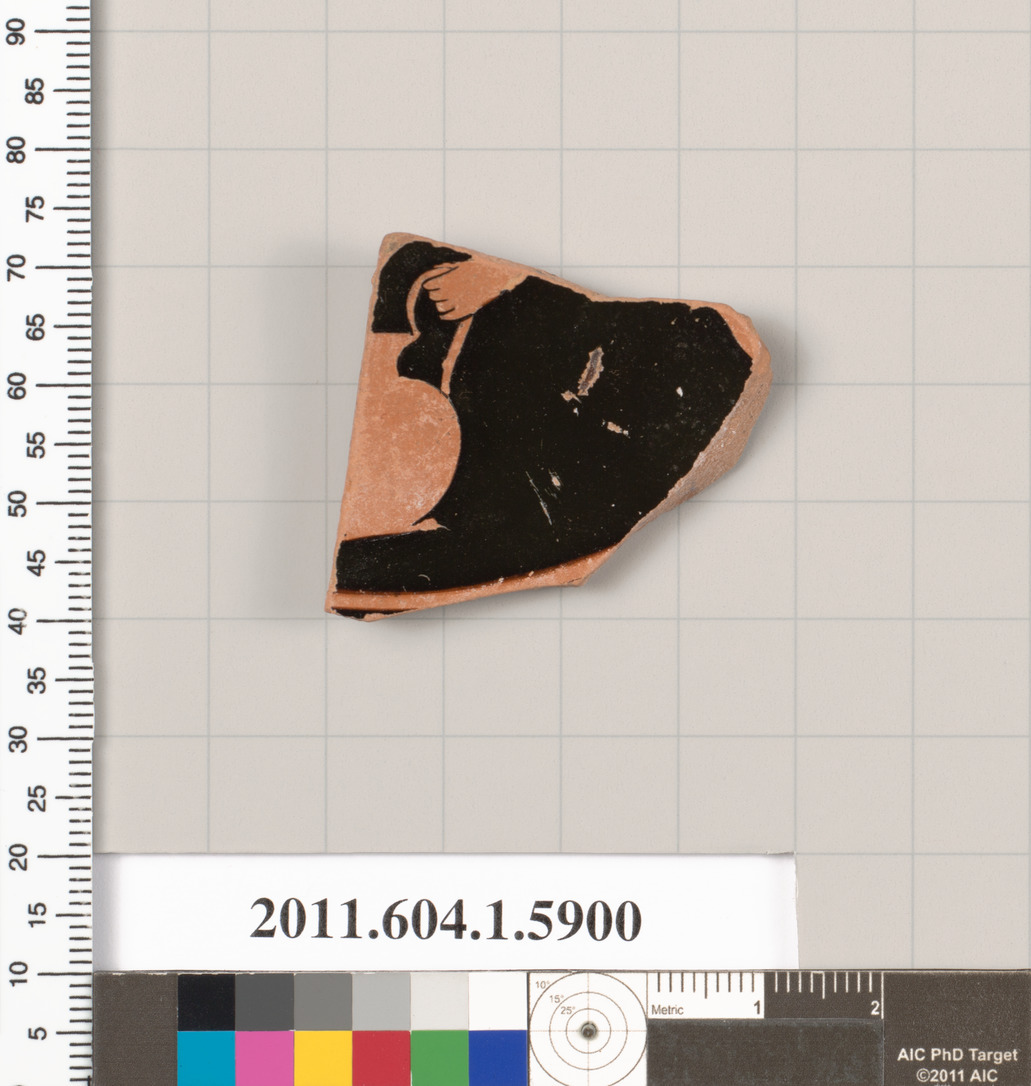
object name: kylix fragment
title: Terracotta fragment of a kylix (drinking cup)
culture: greek, attic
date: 520-510 BCE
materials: terracotta